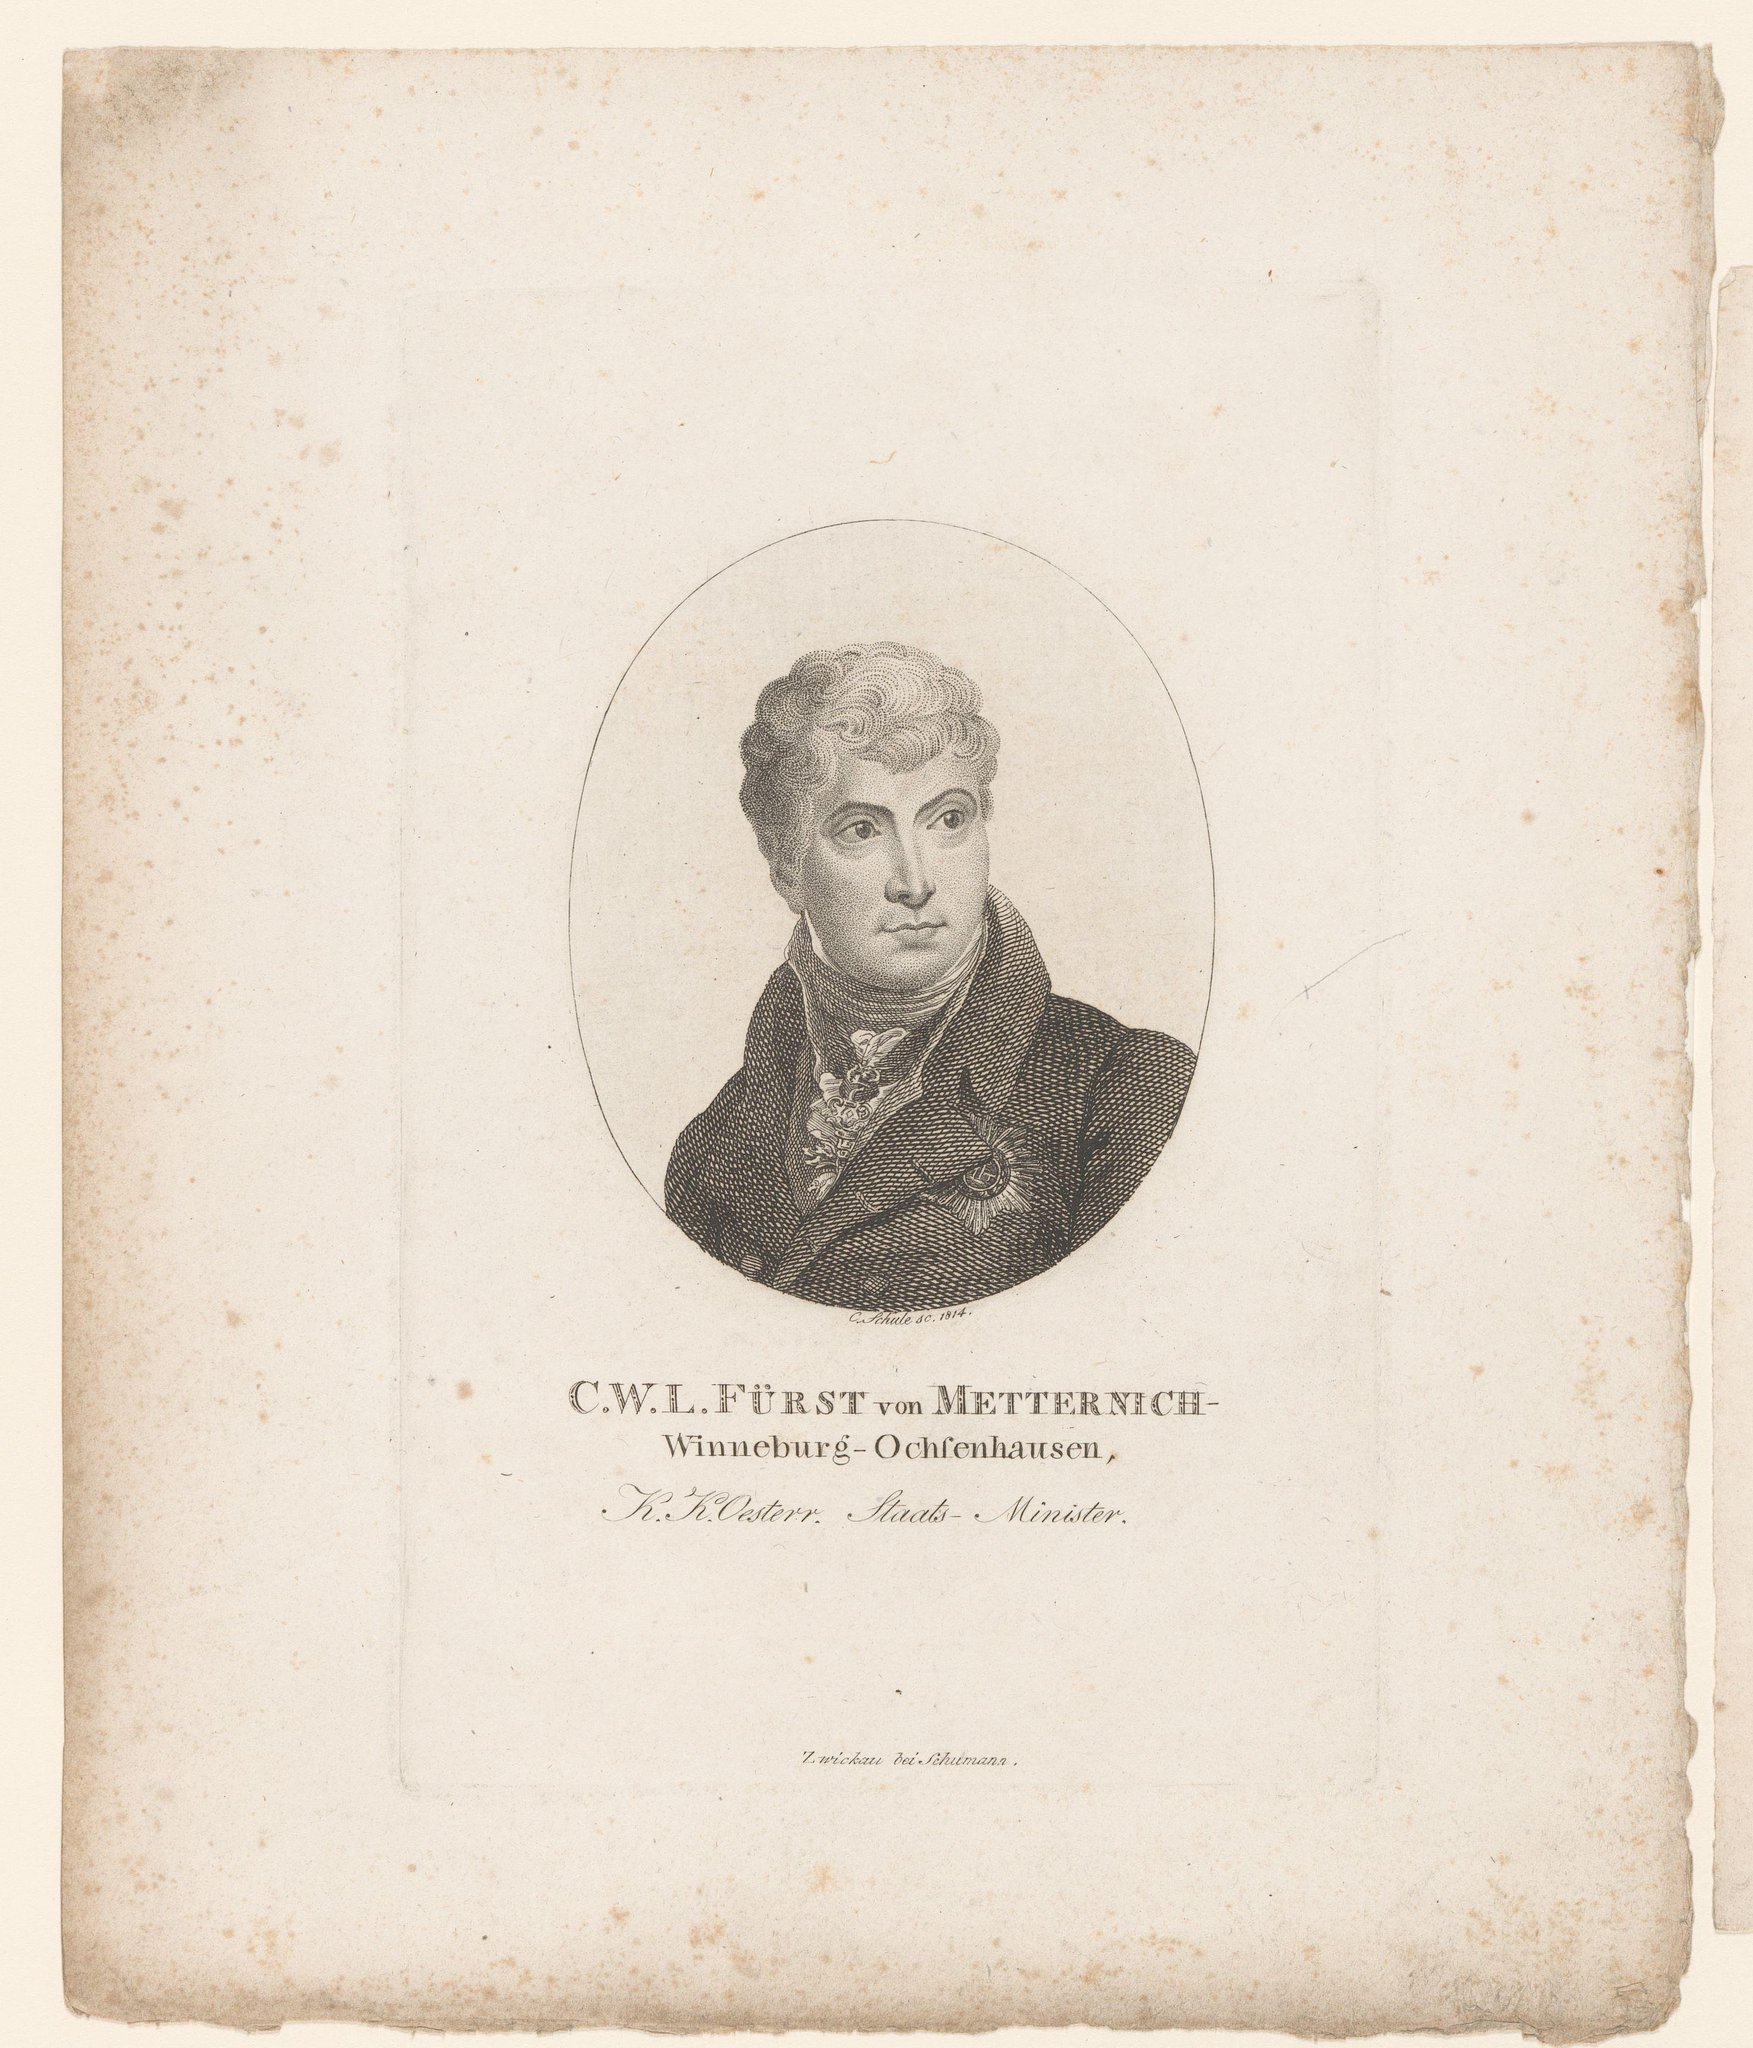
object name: print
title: C.W.L. Fürst von Metternich-Winneburg-Ochsenhausen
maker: christian schule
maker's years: 1764-1816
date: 1814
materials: paper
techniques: engraving, etching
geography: zwickau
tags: vienna, minister ~ government, historical persons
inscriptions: collector's mark: Lugt 2228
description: Portret van Klemens von Metternich (Fürst Clemens Wenceslaus Nepomuk Lothar von Metternich-Winneburg zu Beilstein), Oostenrijks staatsman.